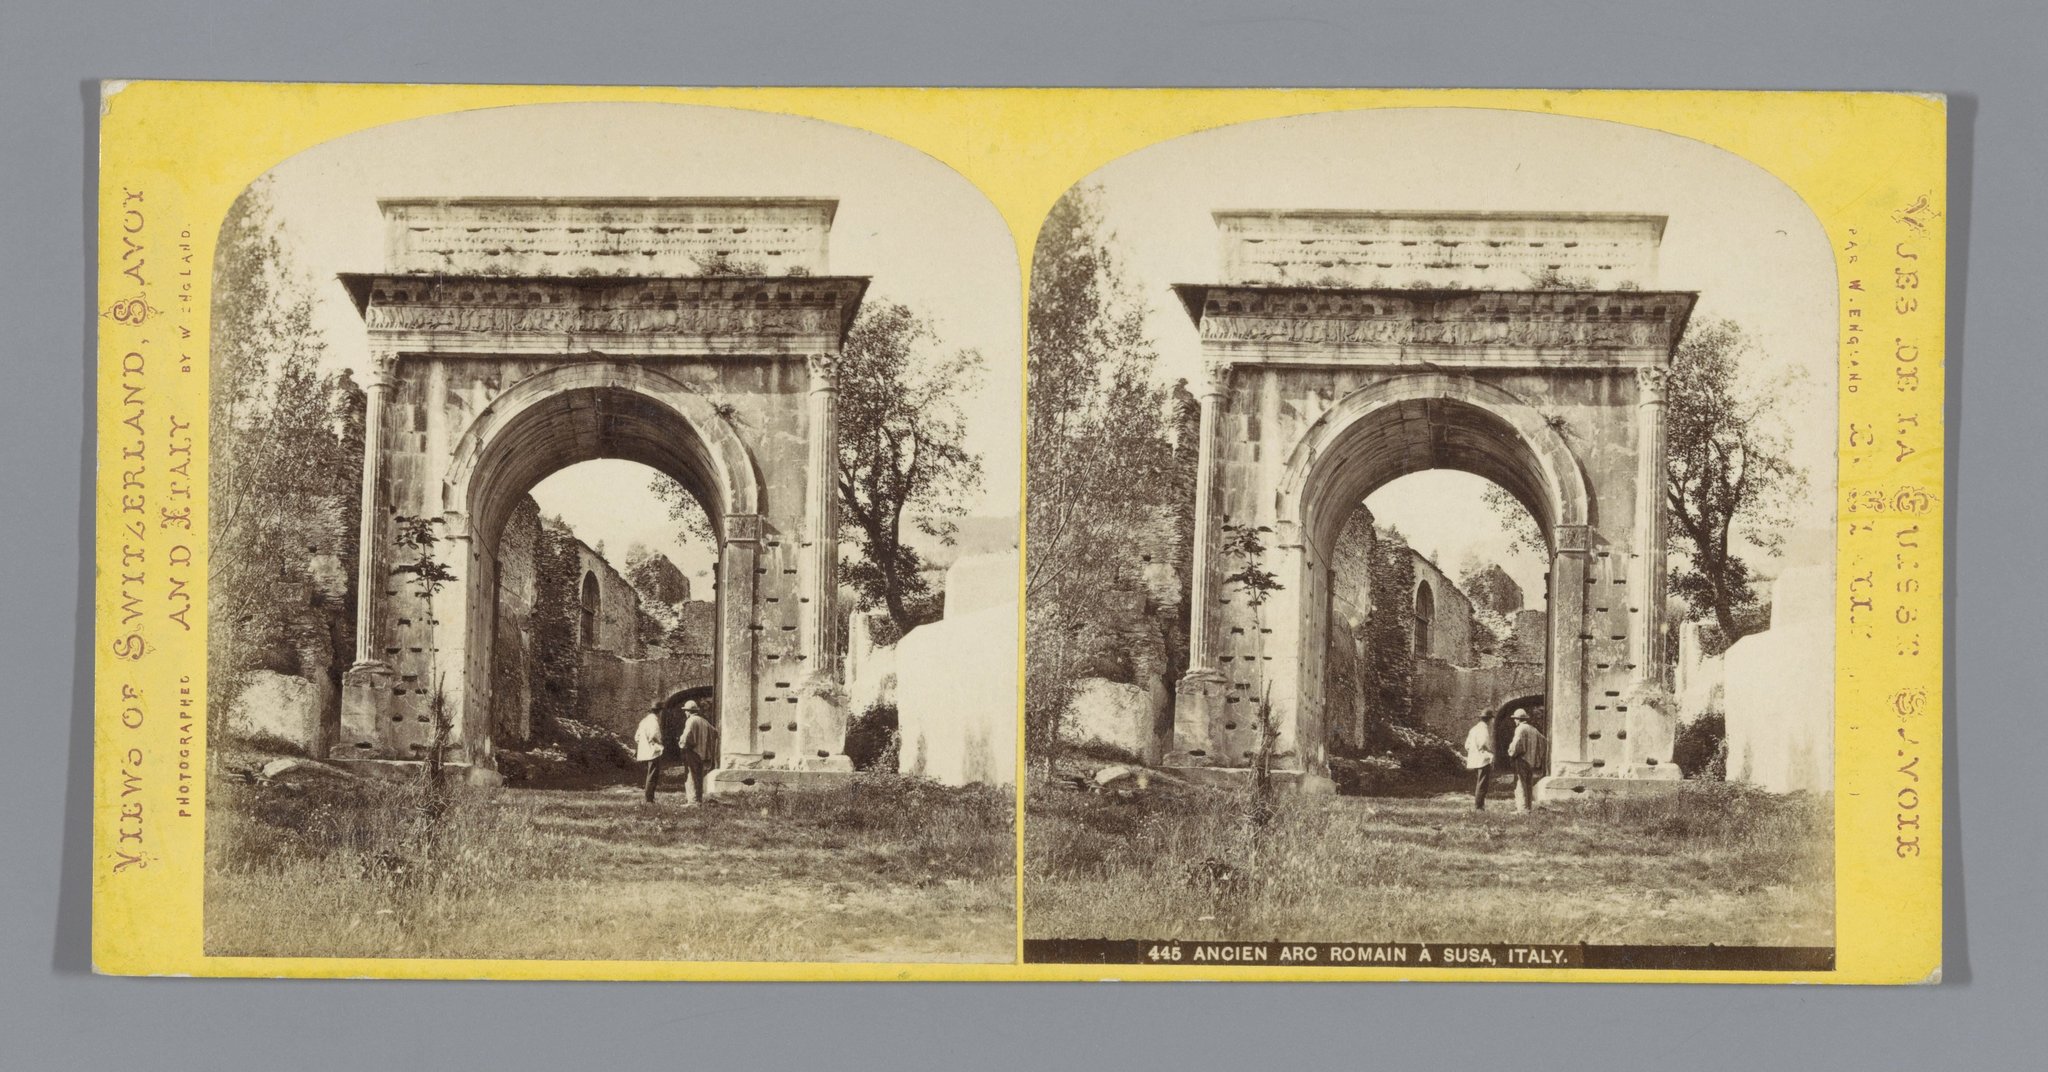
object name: stereograph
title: Gezicht op een Romeinse triomfboog in Susa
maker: william england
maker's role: fotograaf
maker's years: 1816-1896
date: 1850-1880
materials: cardboard, photographic support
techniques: albumen print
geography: susa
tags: arch, archivolt ~ architecture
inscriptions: number: ‘445’, inscription: ‘Vues de la Suisse Savoie et Italie’